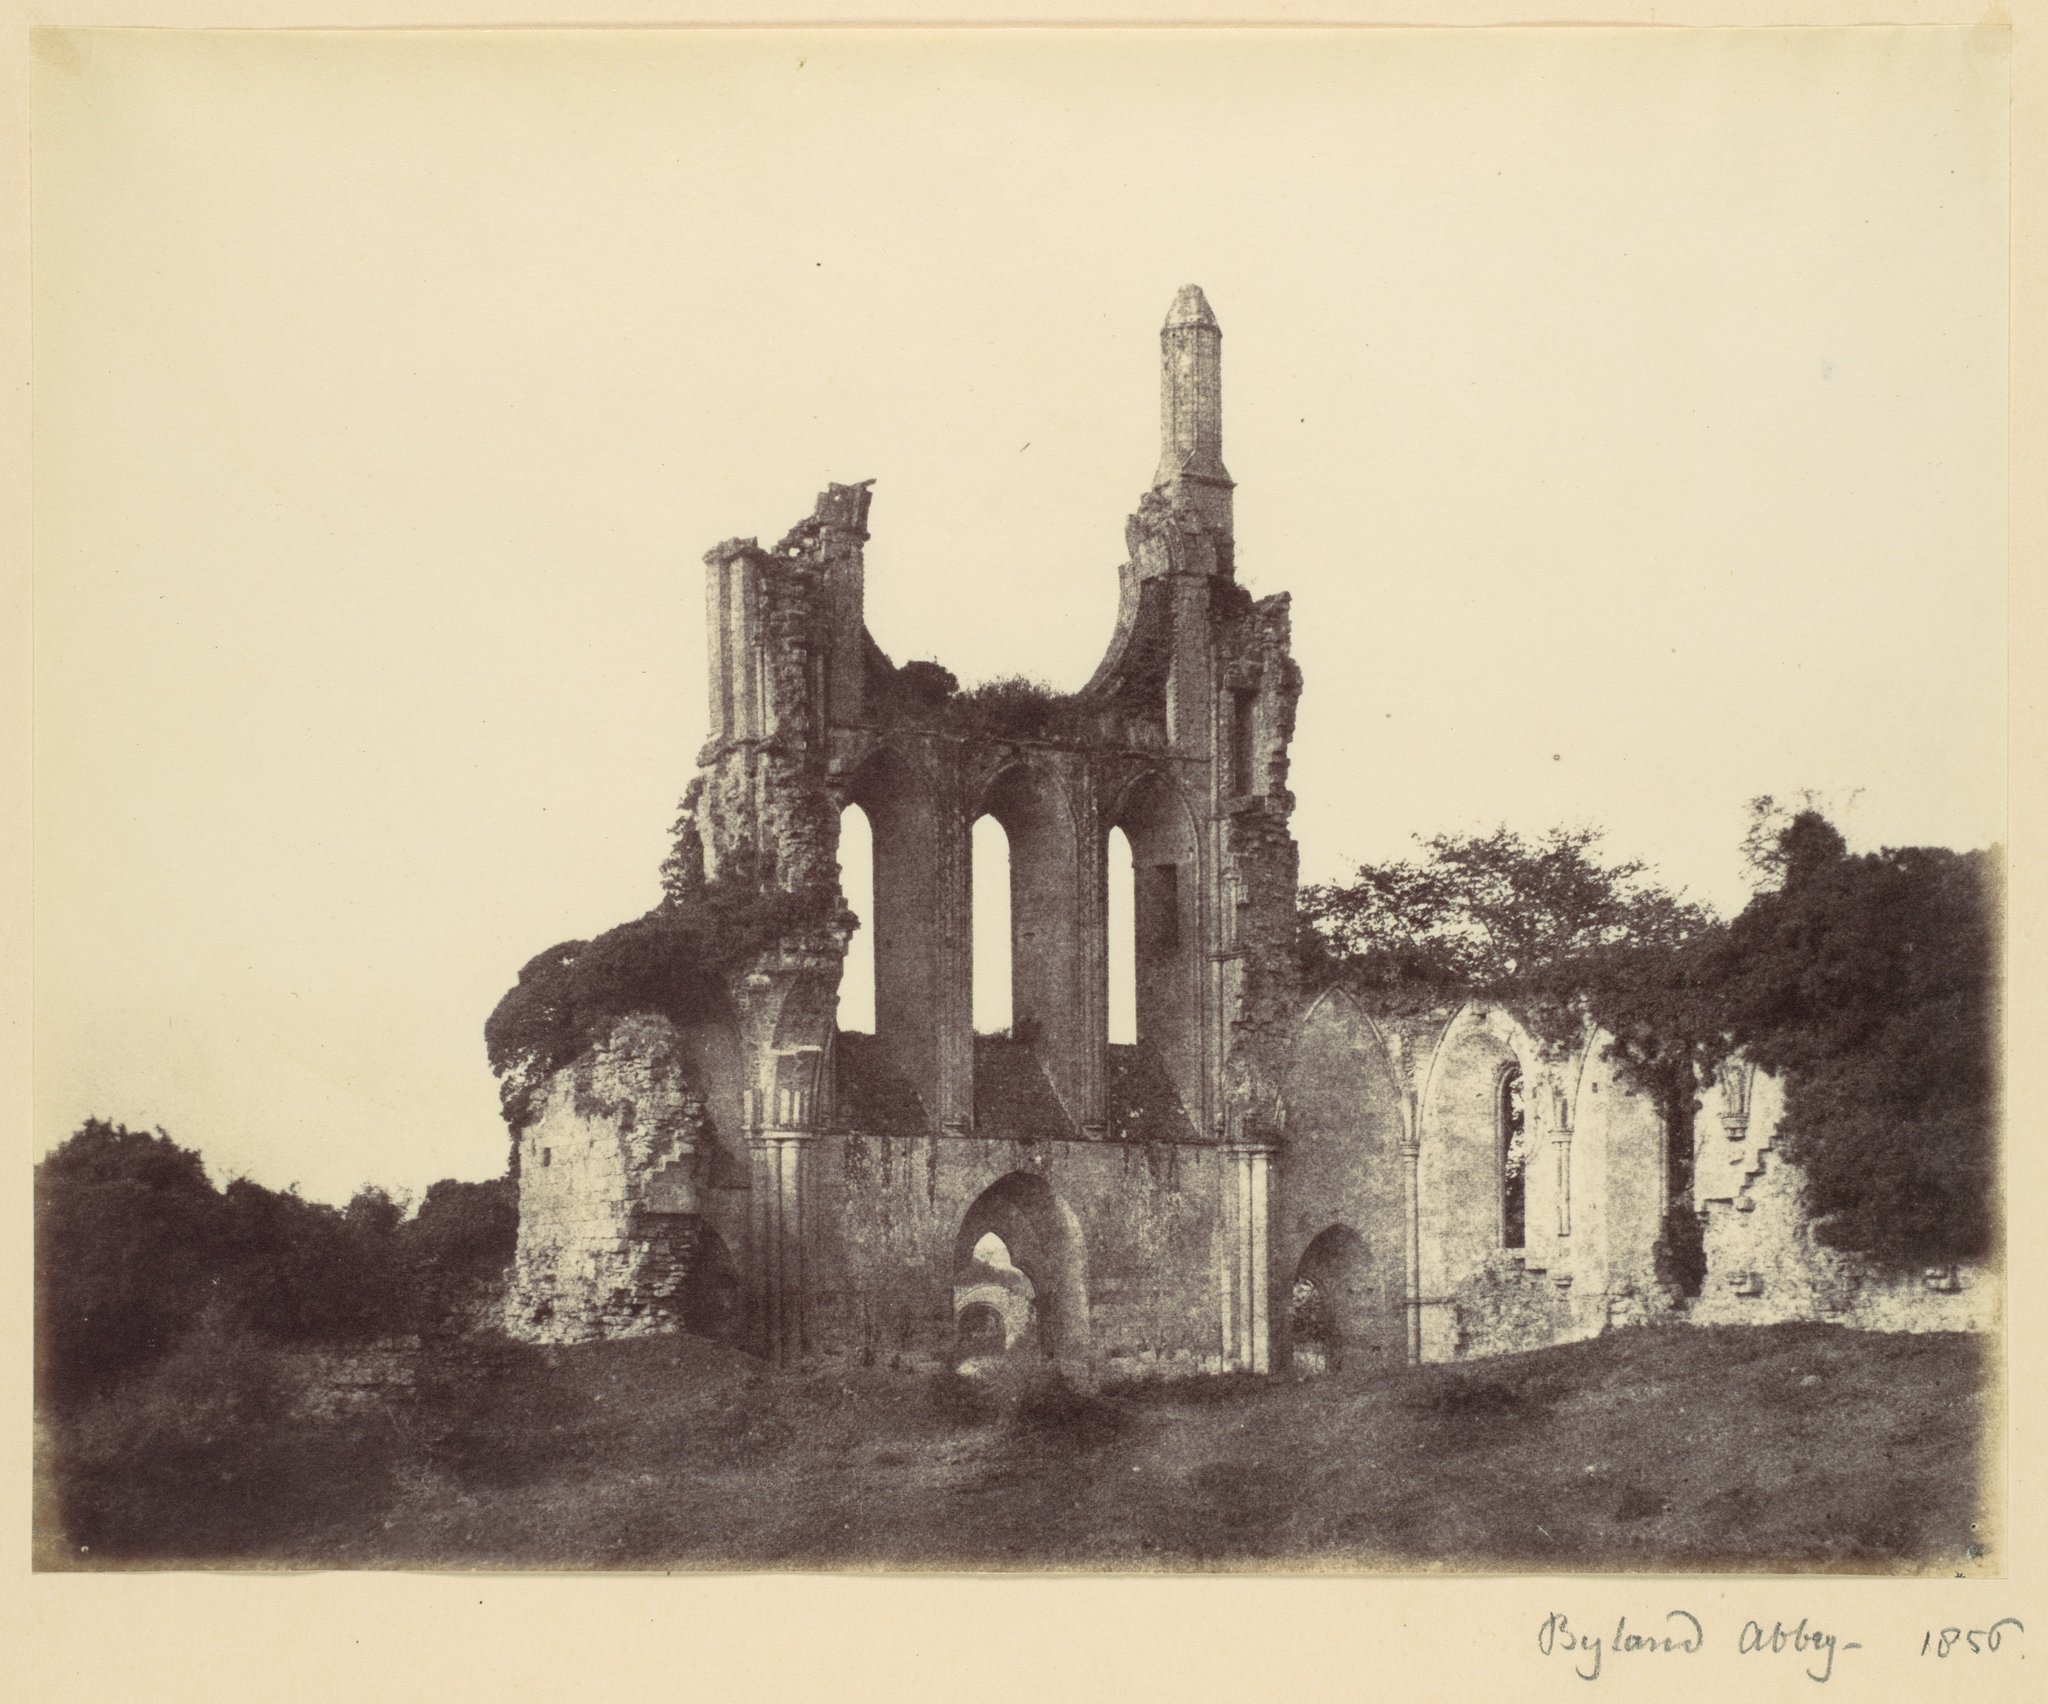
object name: photograph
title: Byland Abbey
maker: alfred capel cure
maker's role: artist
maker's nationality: british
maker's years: 1826-1896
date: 1856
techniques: albumen silver print, paper negative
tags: architecture,abbeys,ruins